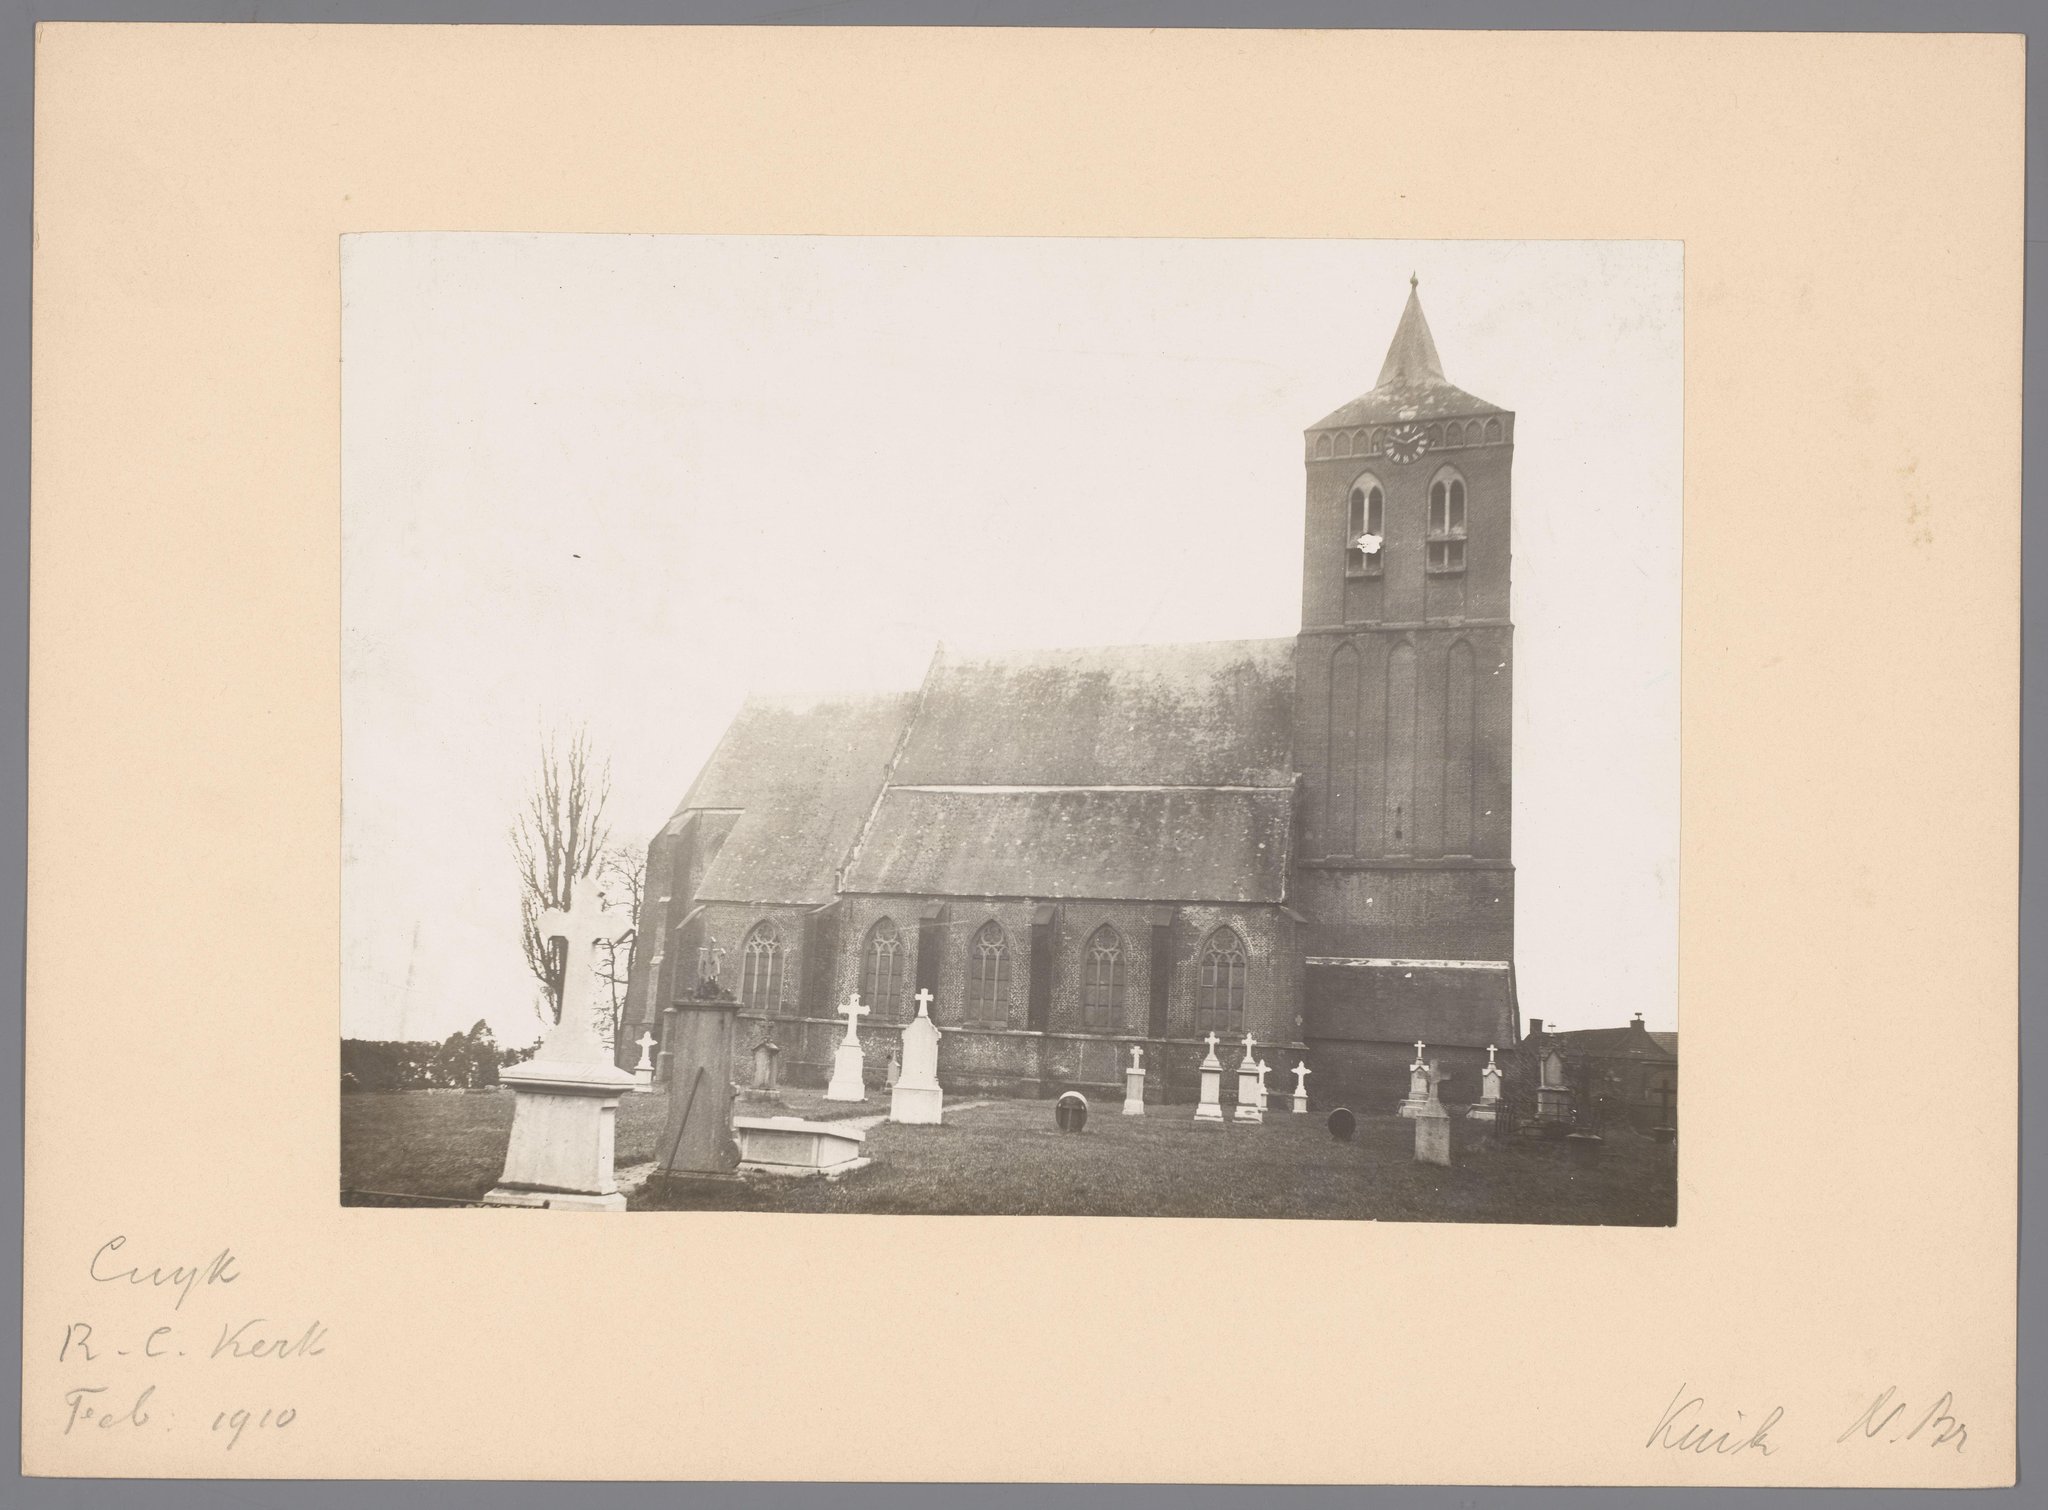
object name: photograph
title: Gezicht op de oude Sint-Martinuskerk te Cuijk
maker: anoniem (monumentenzorg)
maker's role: fotograaf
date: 1910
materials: cardboard, photographic support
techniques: gelatin silver print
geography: cuijk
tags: church (exterior), churchyard, cemetery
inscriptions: annotation: ‘Cuijk/ R-C. Kerk/ Feb: 1910/ Kuik N.Br.’